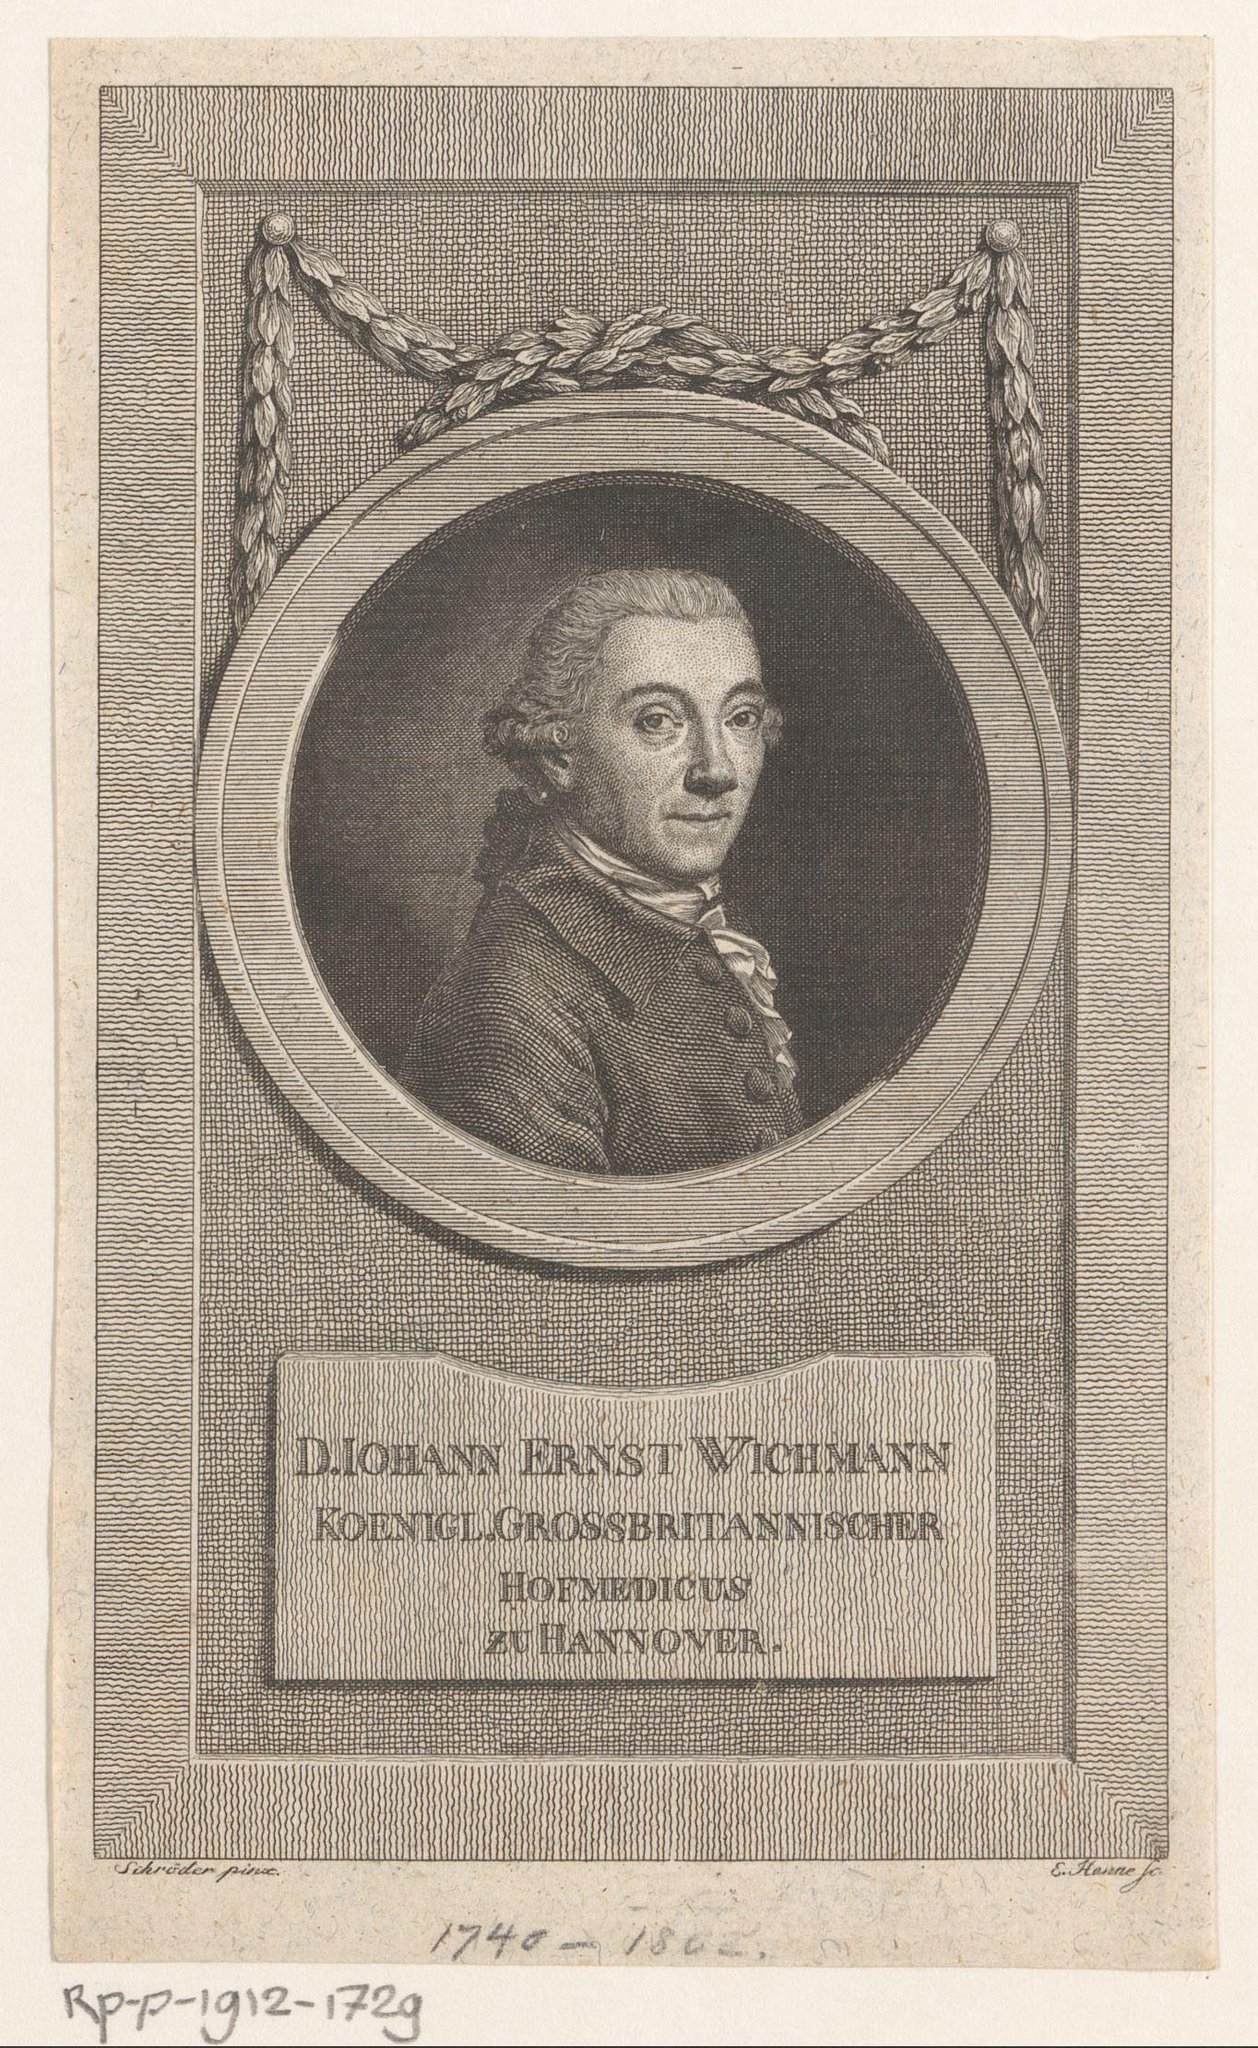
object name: print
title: Portret van Johann Ernst Wichmann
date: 1769-1802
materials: paper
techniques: engraving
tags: historical persons, physician, doctor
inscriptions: collector's mark: Lugt 2228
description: Prent gebruikt voor: Allgemeine deutsche Bibliothek. Berlijn en Stettin: Friedrich Nicolai, 1786, dl. 70.